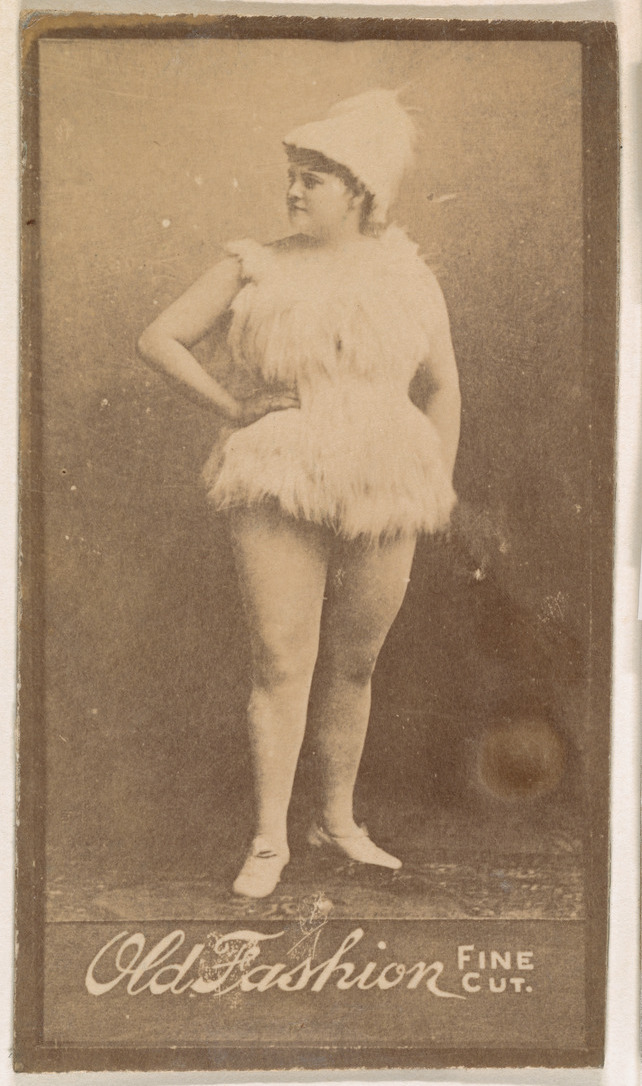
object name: photograph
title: Actress wearing feathered costume, from the Actresses series (N664) promoting Old Fashion Fine Cut Tobacco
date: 1888-1890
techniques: albumen silver print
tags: portraits,women,actresses